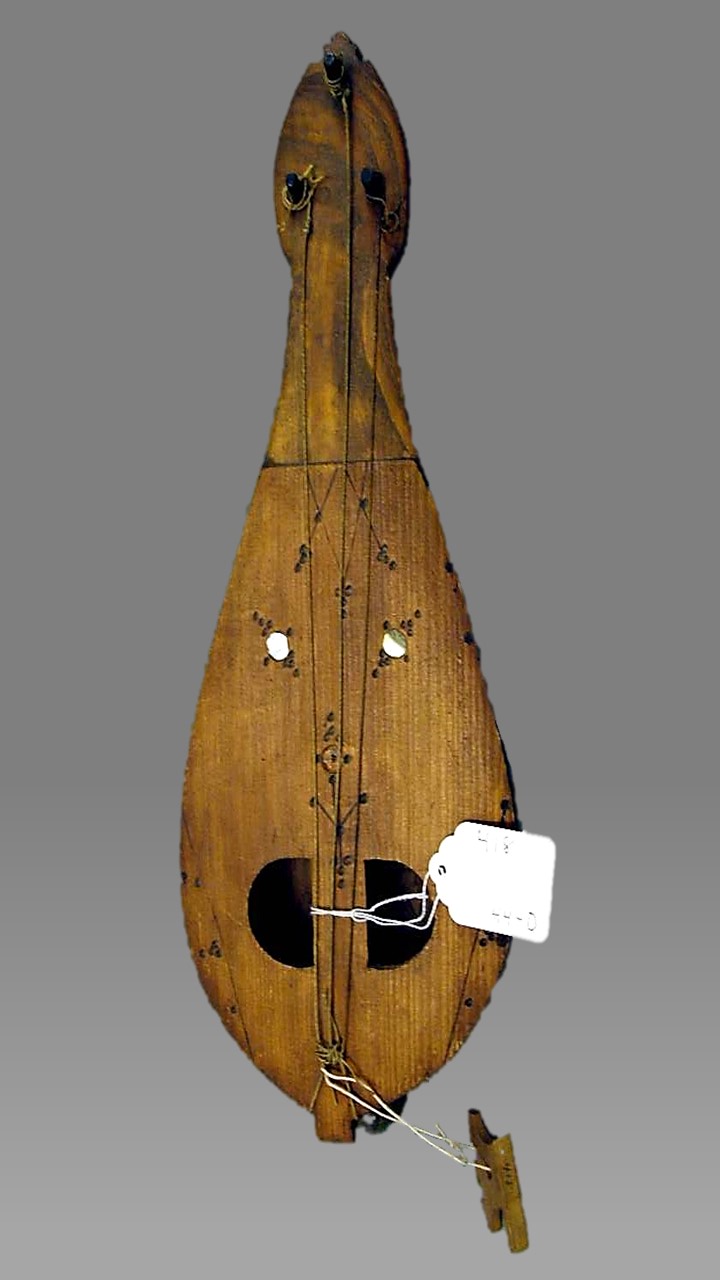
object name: kemenche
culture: bulgarian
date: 1867-1900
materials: wood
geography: egypt